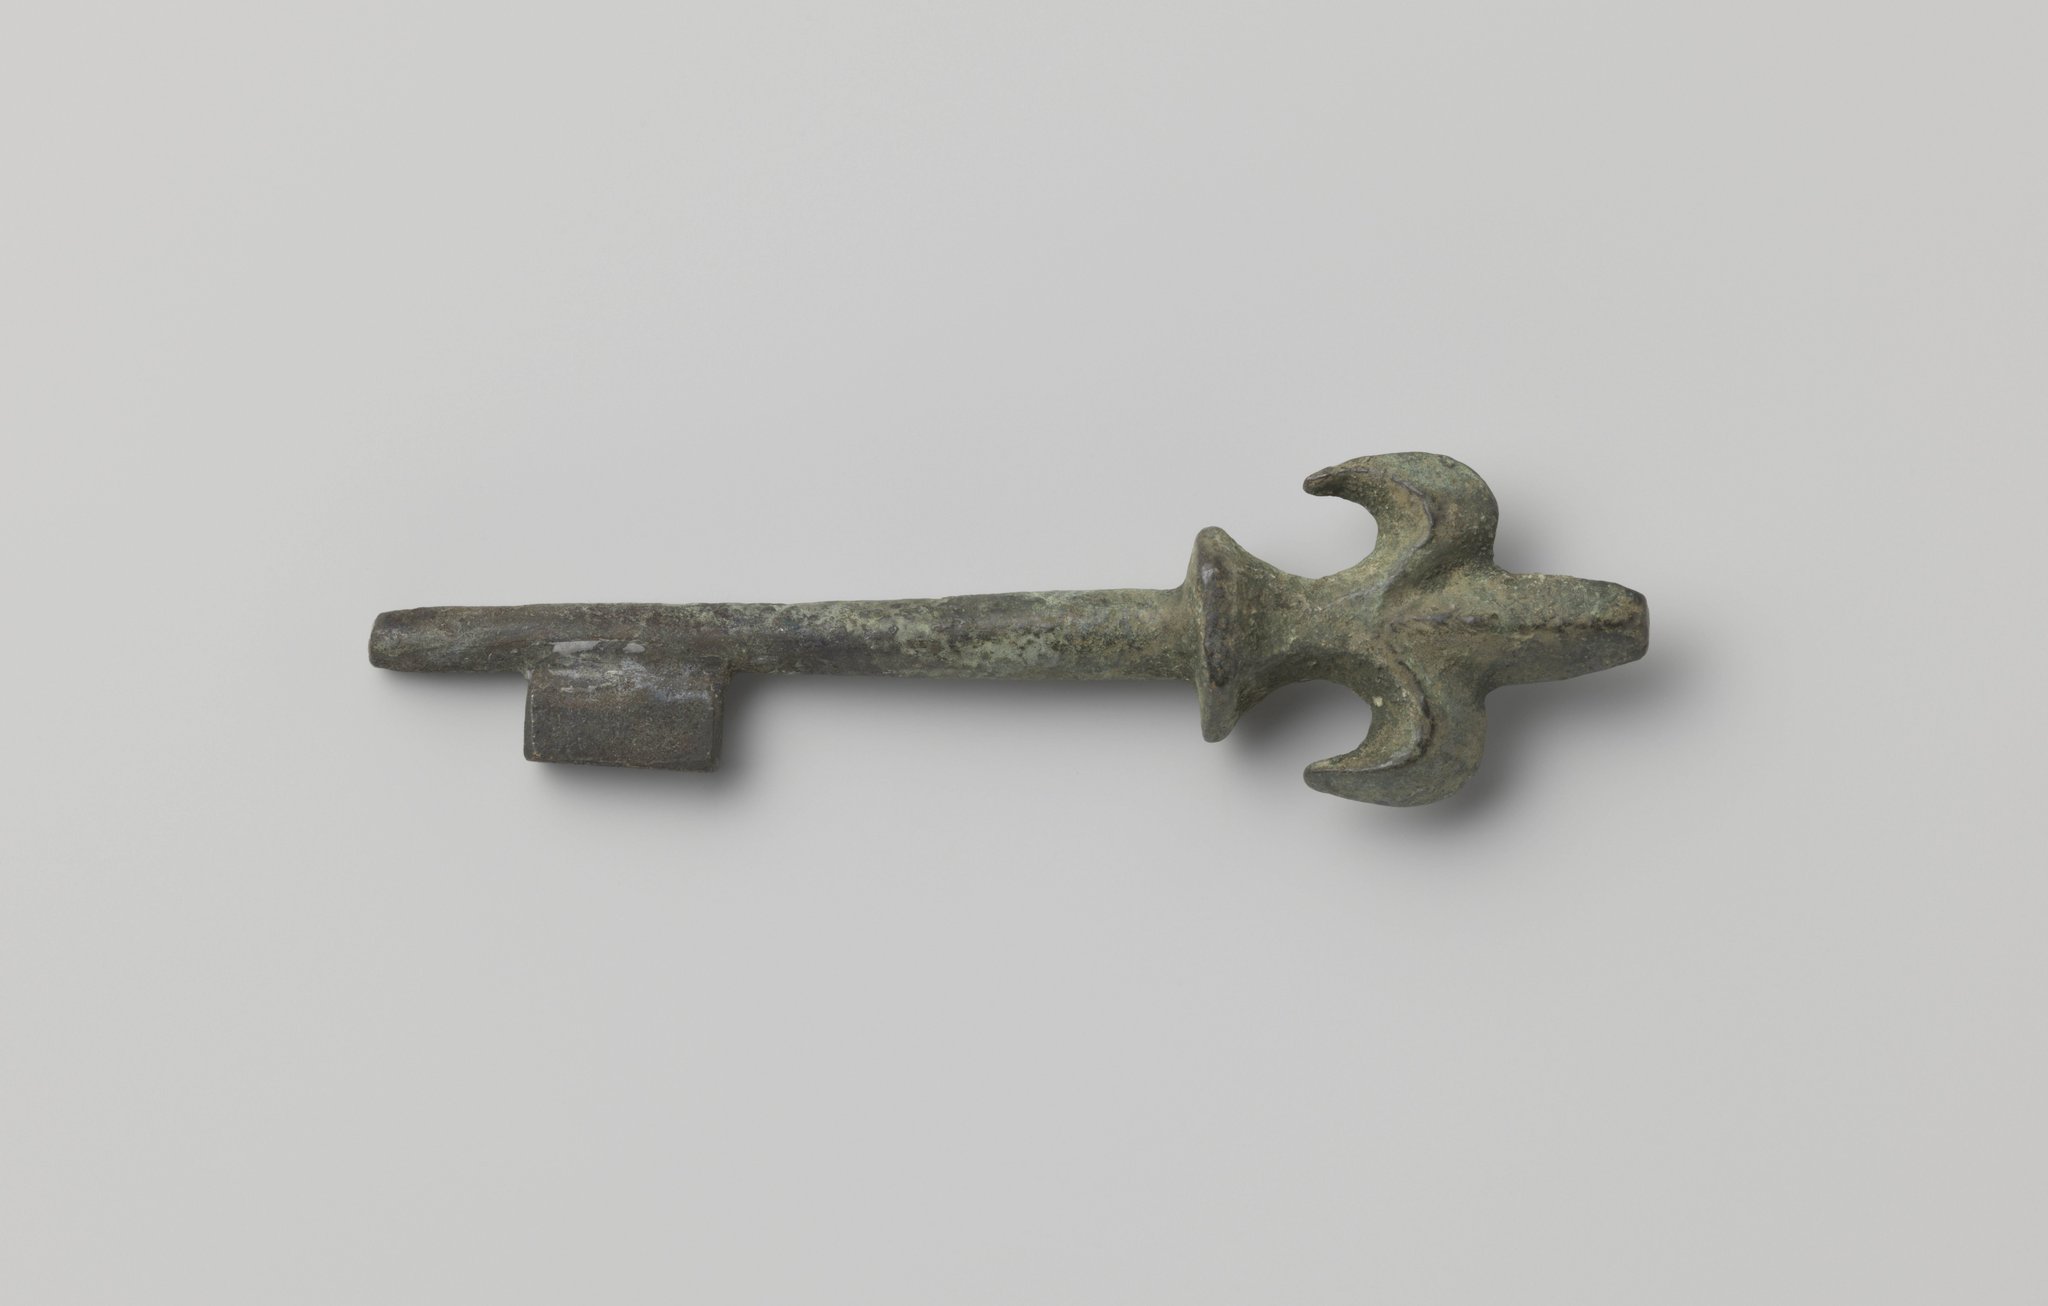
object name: key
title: 39 keys from the collection of Emmanuel Vita Israël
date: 1200-1400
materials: bronze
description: The Amsterdam apothecary and art collector Emmanuel Vita Israël. He donated his collection, comprising keys dating from Roman antiquity to the 19th century, to the Koninklijk Oudheidkundig Genootschap (Royal Antiquarian Society) in 1937. Vita Israël claimed that his key collection had grown more or less by accident: being one of the few collectors of keys, dealers automatically made their way to him.